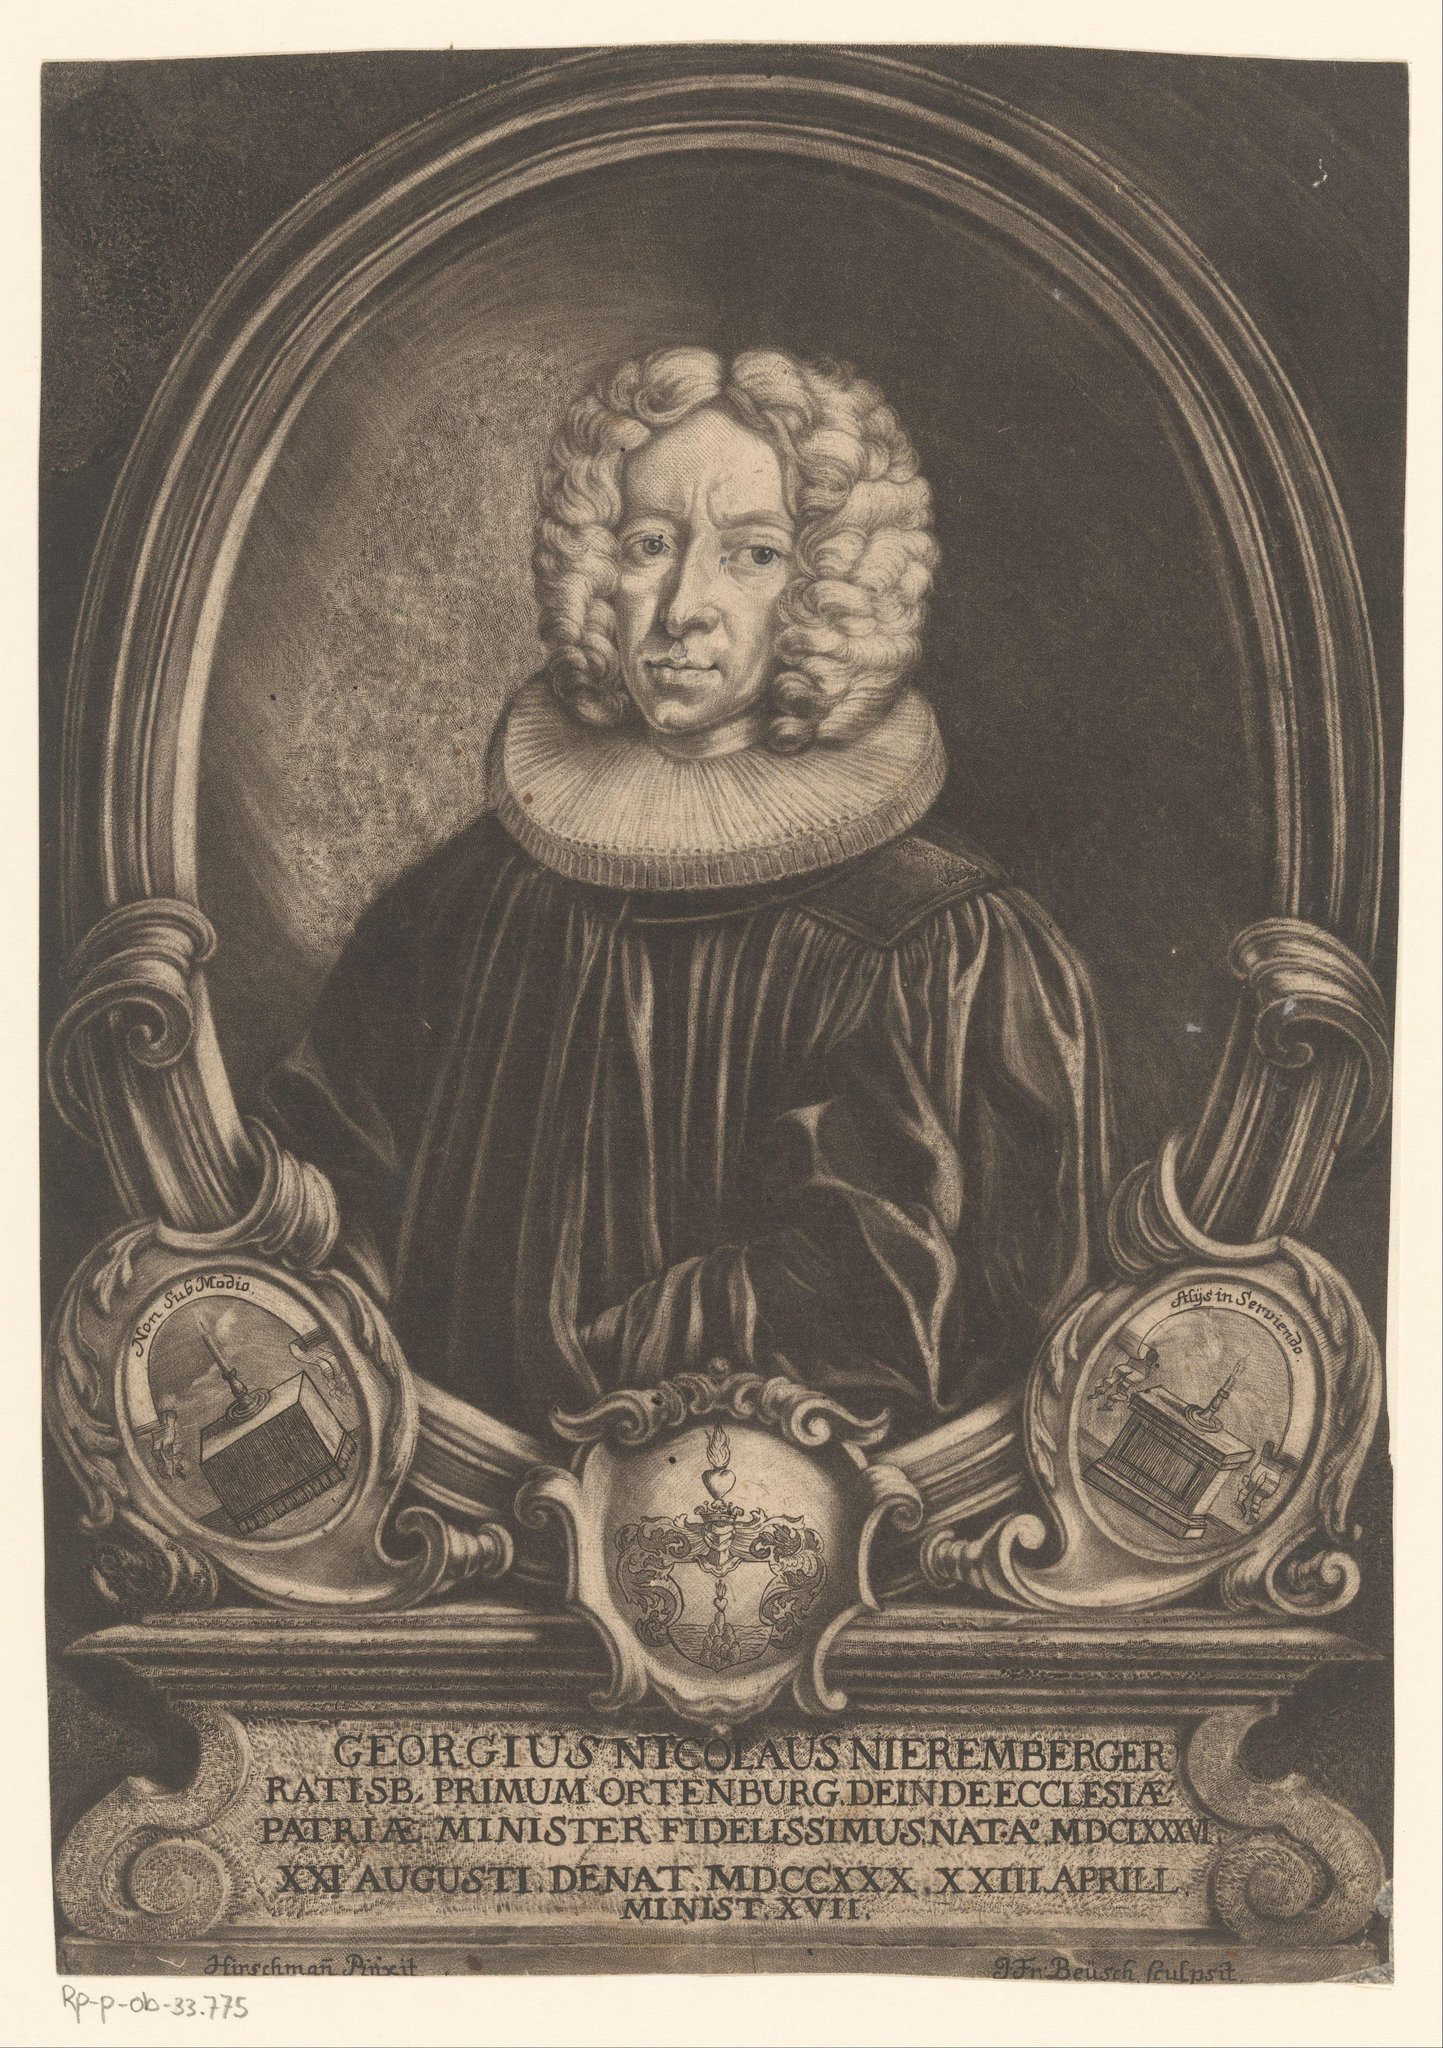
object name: print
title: Portret van Georgius Nicolaus Nieremberger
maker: johann friedrich beusch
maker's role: print maker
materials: paper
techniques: mezzotint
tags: historical persons, abstract ideas and concepts (+ emblematical representation of concept), armorial bearing, heraldry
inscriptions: collector's mark: Lugt 2228